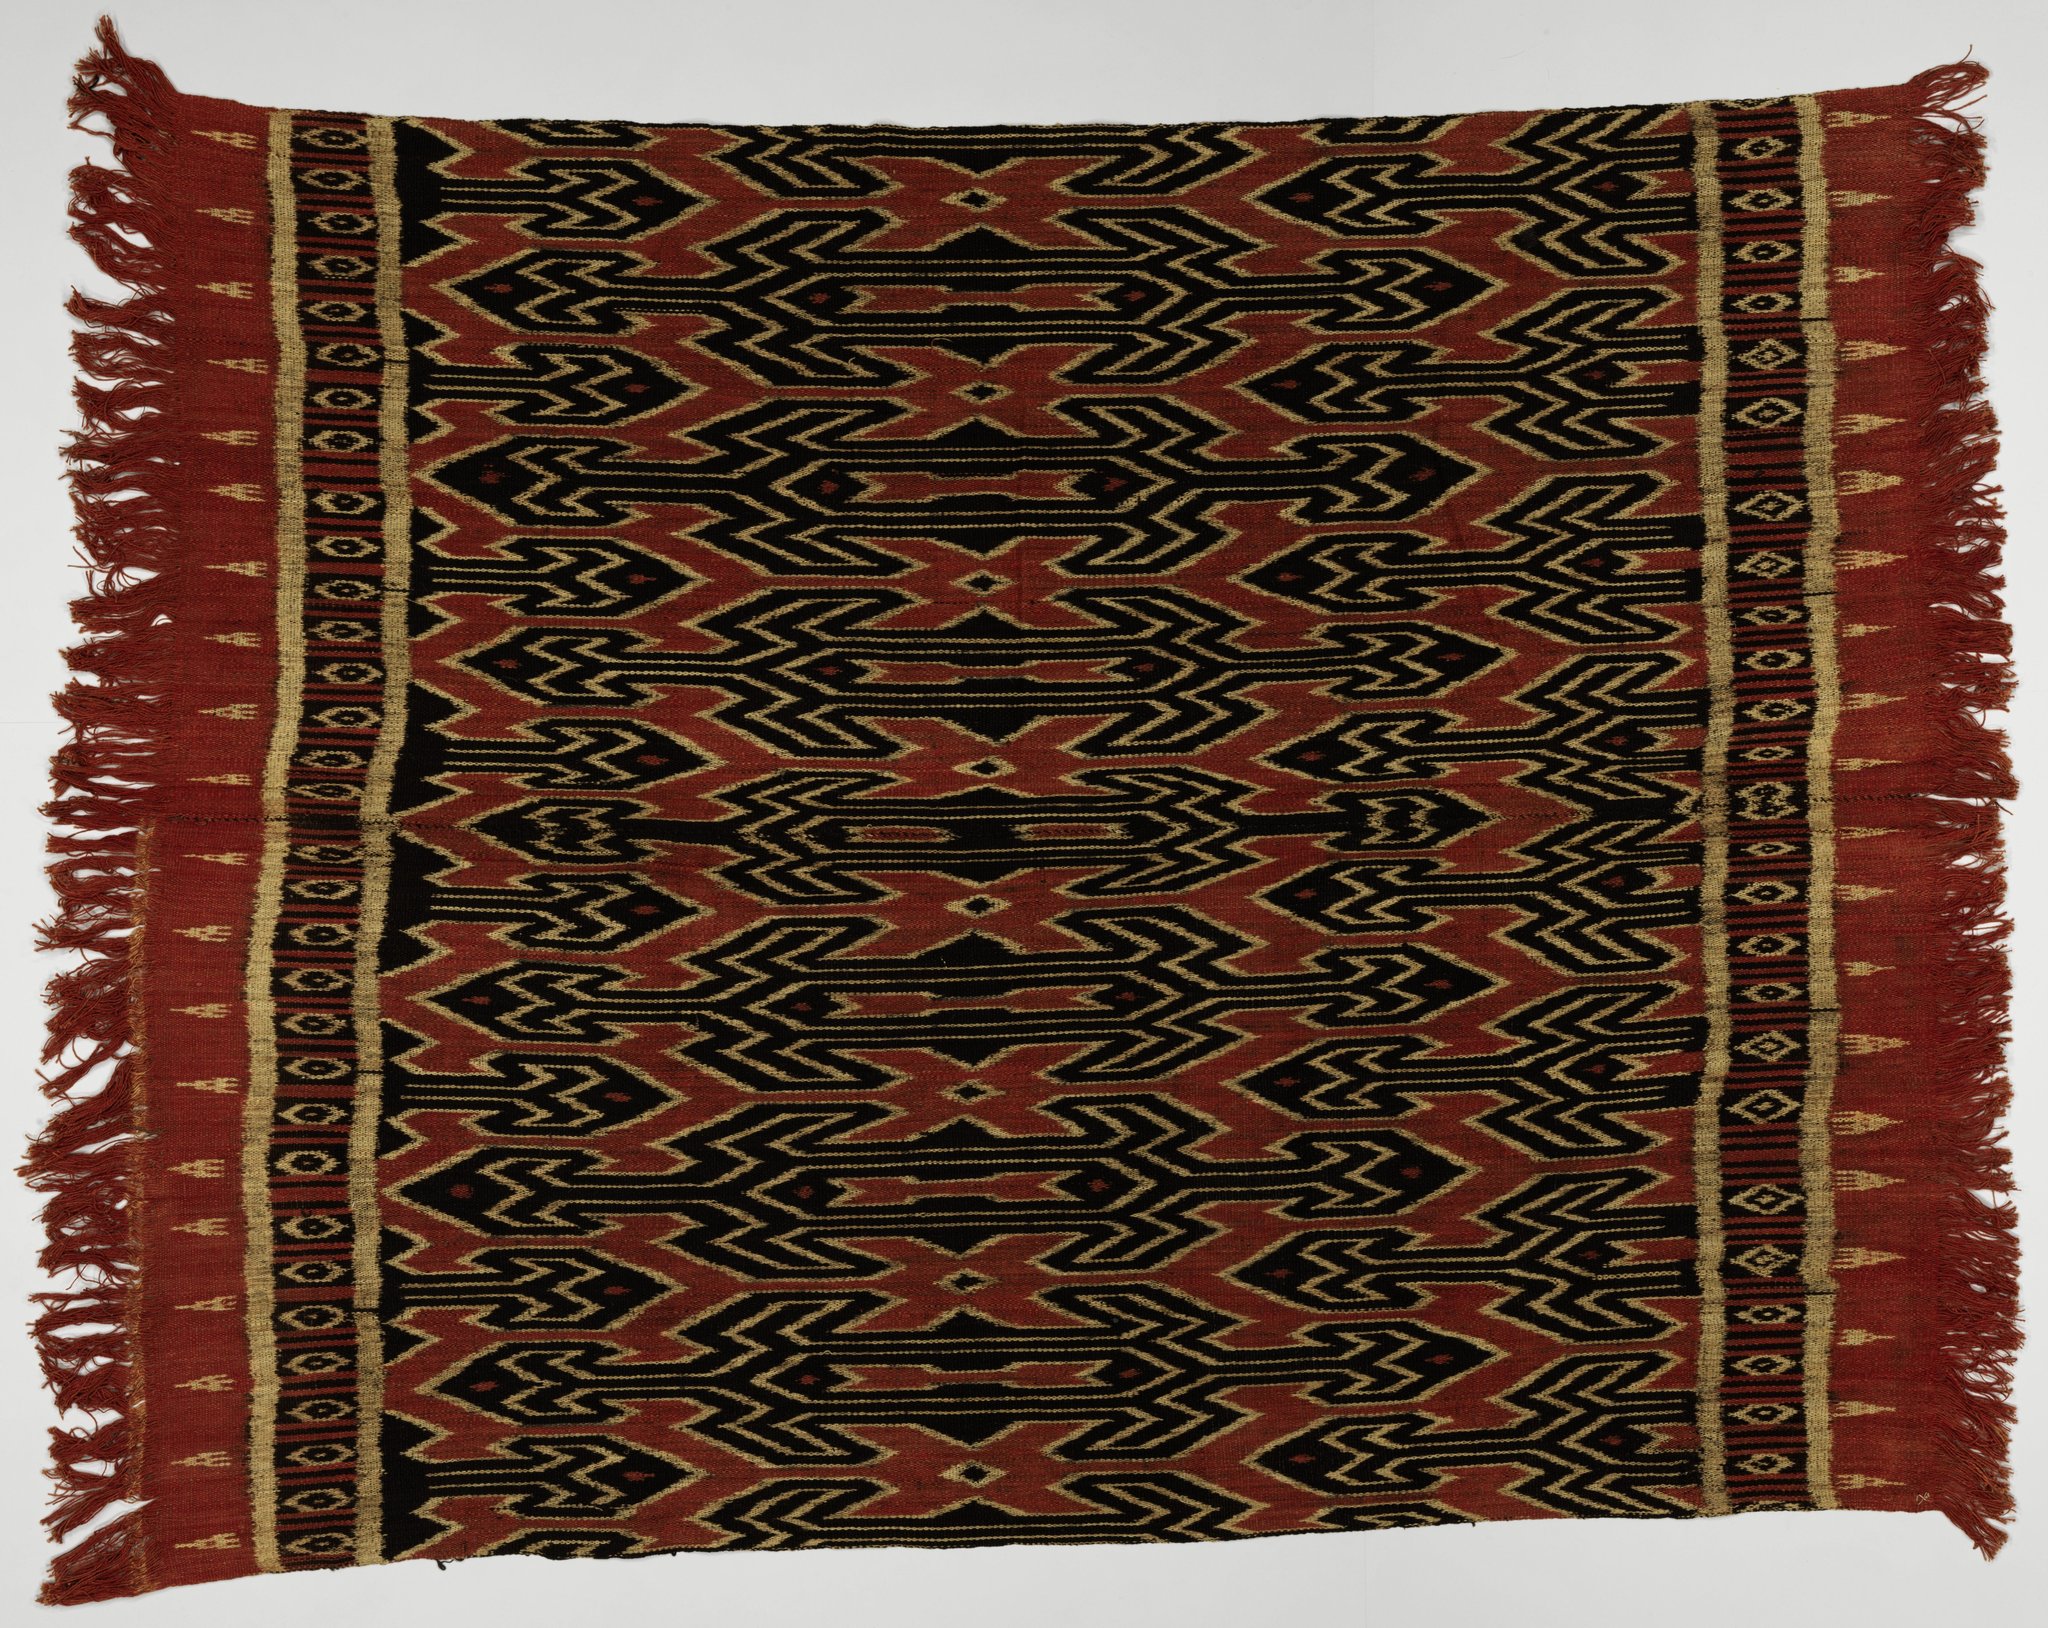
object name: cloth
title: Dodendoek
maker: Anonymous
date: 1900-1949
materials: cotton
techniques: weave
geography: sulawesi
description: De dodendoeken van de Toraja bevolking uit Centraal Sulawesi behoren tot de meest spectaculaire doeken van de archipel. Ze zijn meer dan vier meter lang en versierd met slangenhuid-achtige (patola) motieven. De doeken zijn buiten het Toraja gebied vervaardigd. Deze doeken zijn gebruikt als wandversiering in de doodskamer, als lijkwade of als kleding. De doeken hebben de typische Toraja kleuren: zwart, rood en wit. Zwart symboliseert het einde van het leven en rood het bloed van offerdieren. Wit is de kleur van de allerhoogste Godheid. Gestreepte zijpanelen ontbreken.